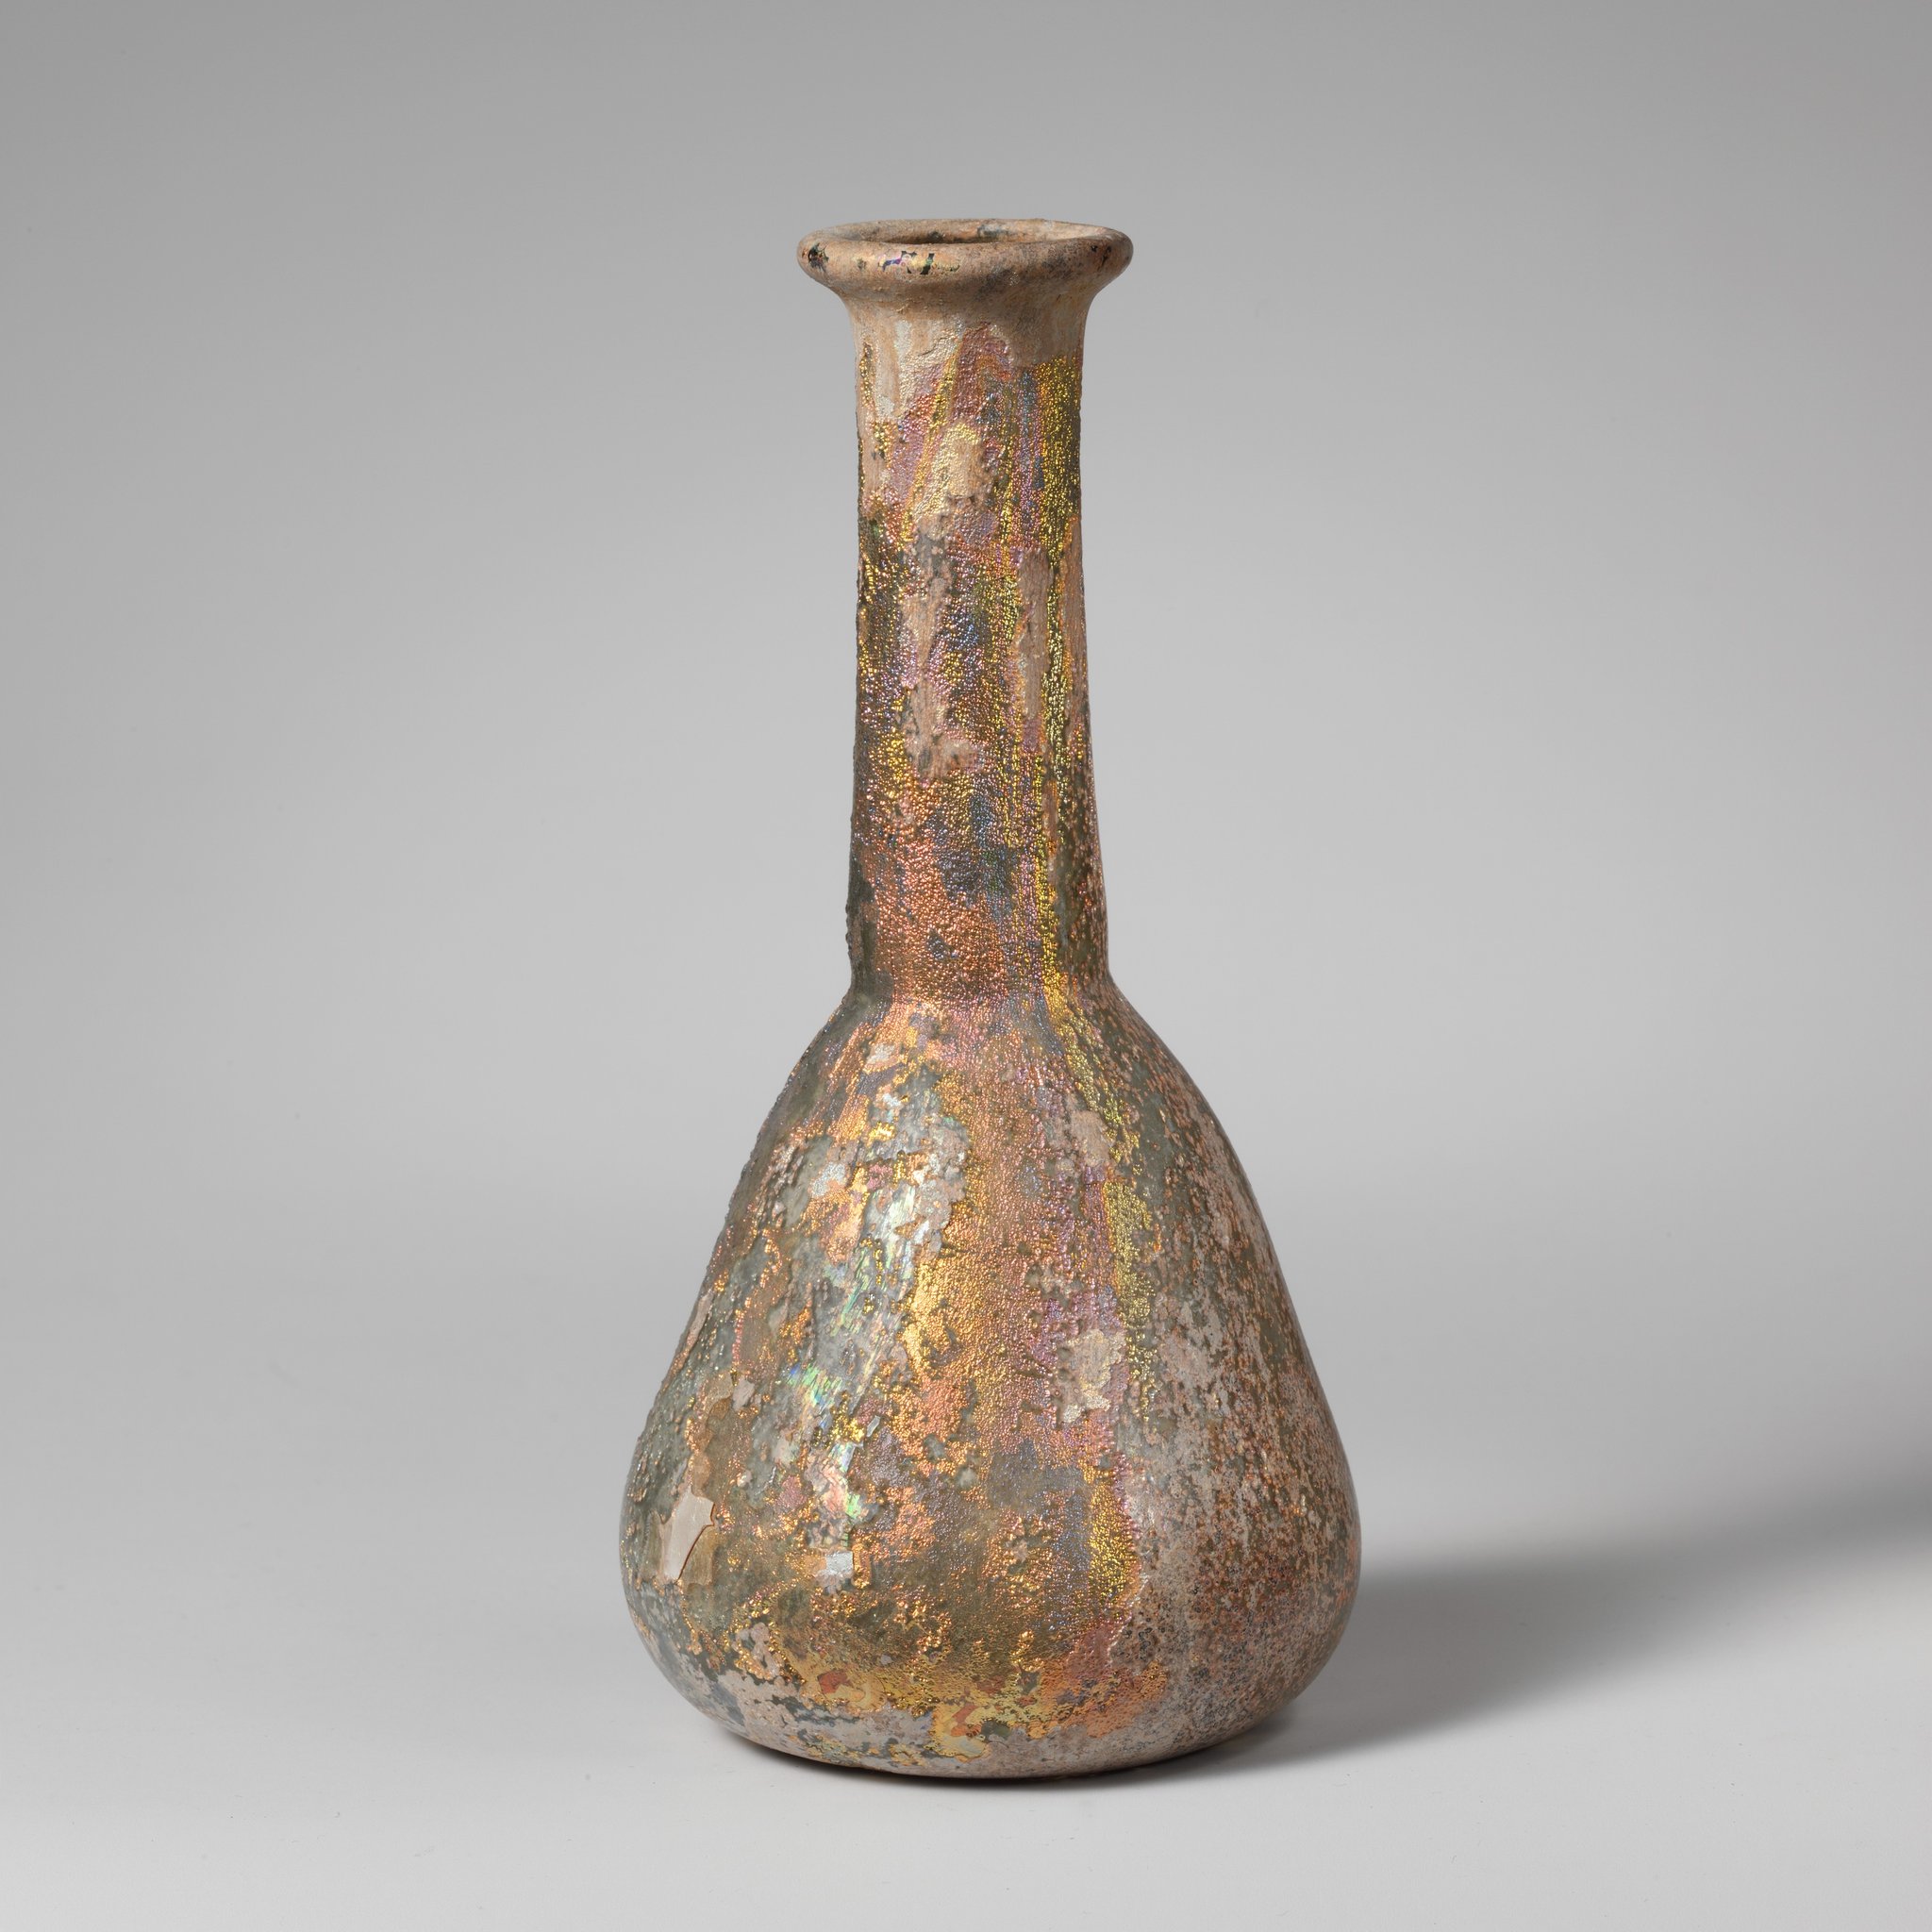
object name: perfume bottle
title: Glass perfume bottle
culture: roman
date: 101-300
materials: glass